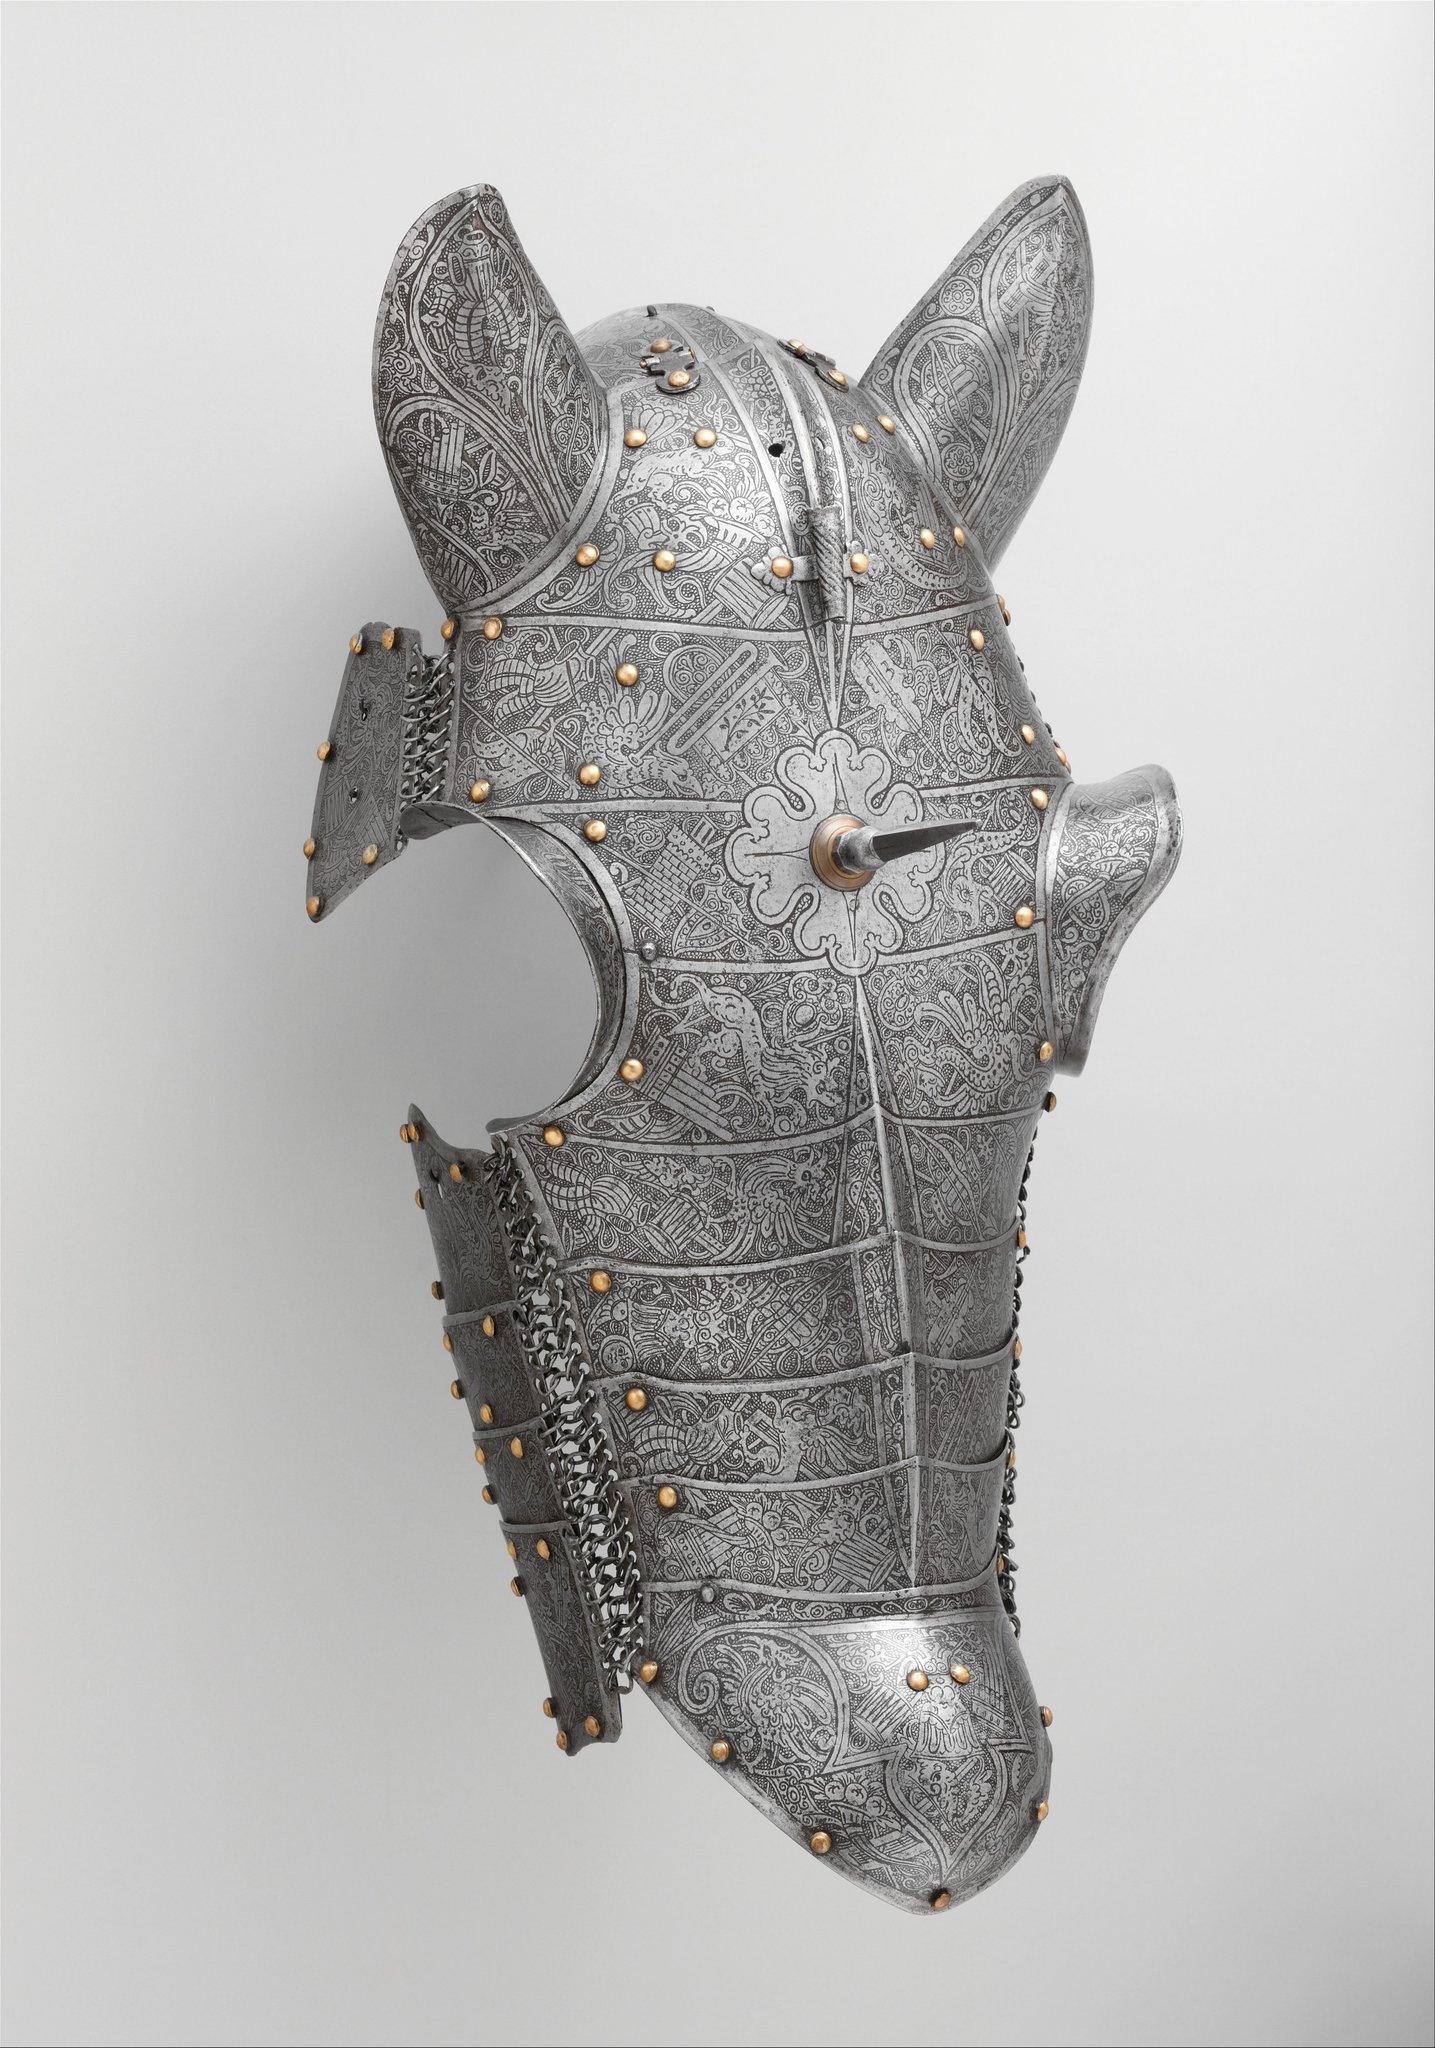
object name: shaffron horse's head defense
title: Shaffron (Horse's Head Defense)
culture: italian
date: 1560-1570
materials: brass, leather, steel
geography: italy